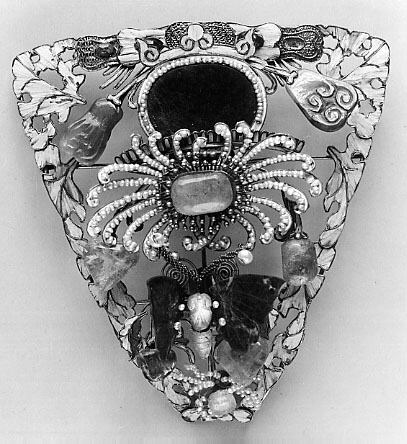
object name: ornament for manzhu hat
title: Ornaments for Manzhu Hat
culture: chinese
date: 1701-1800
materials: coral, feather, glass, jade, metal, pearl, gemstone